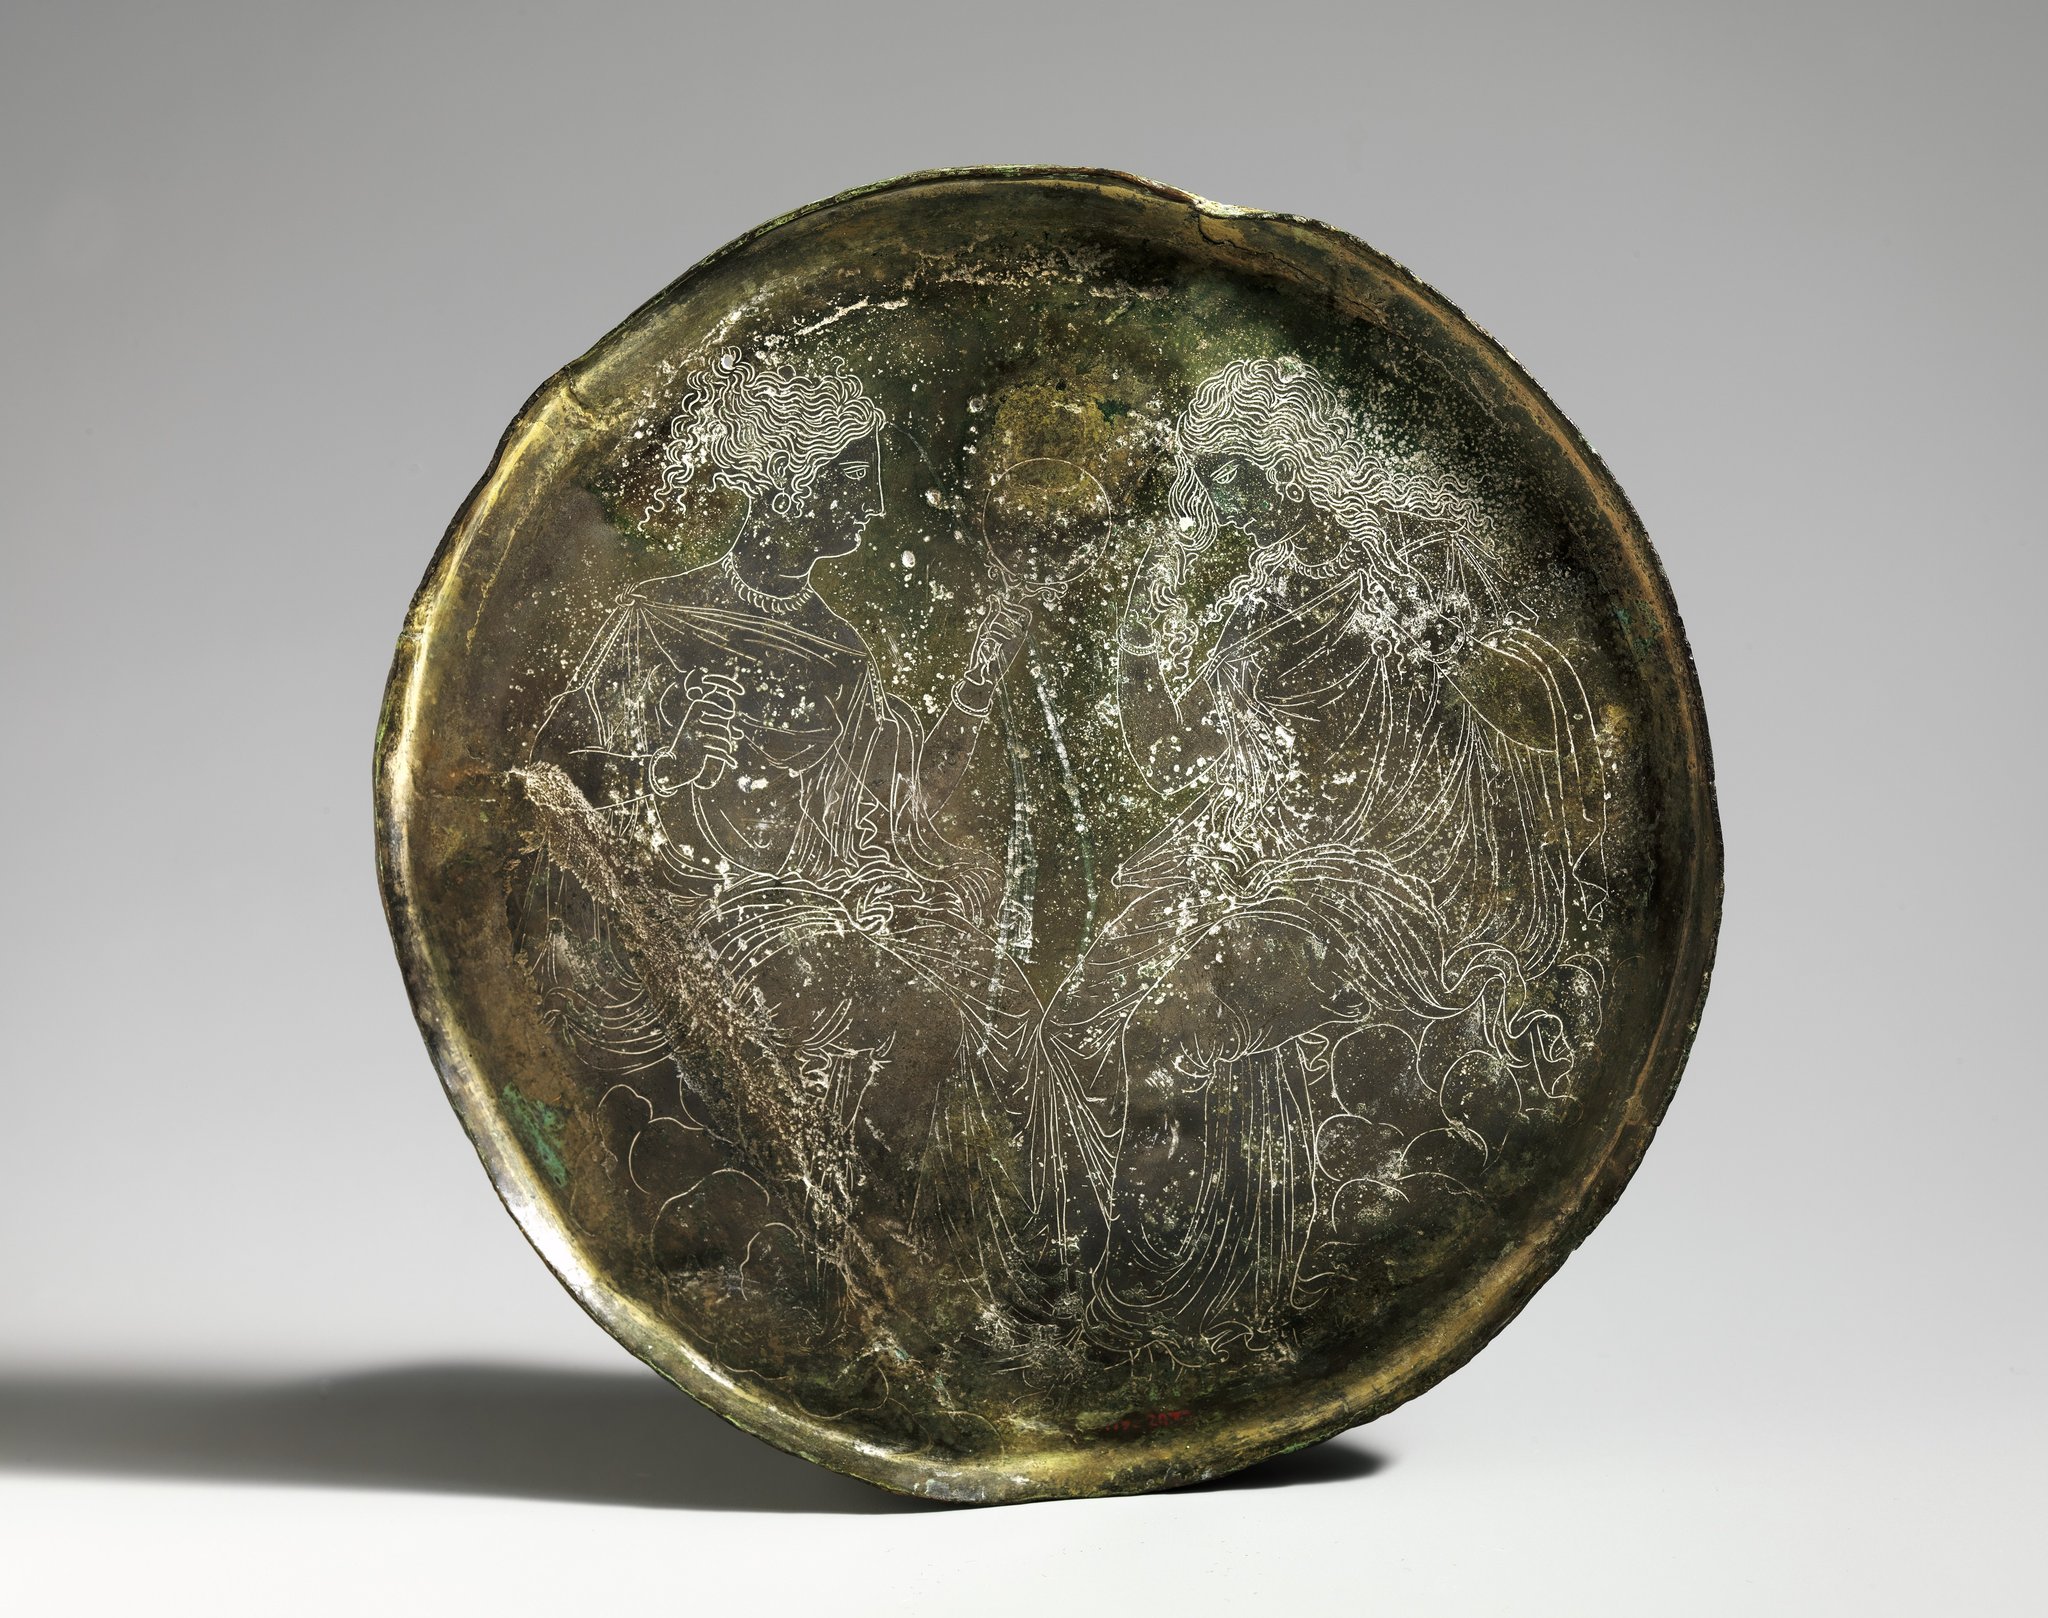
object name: mirror with cover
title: Bronze mirror cover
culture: greek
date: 400-301 BCE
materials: bronze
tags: women